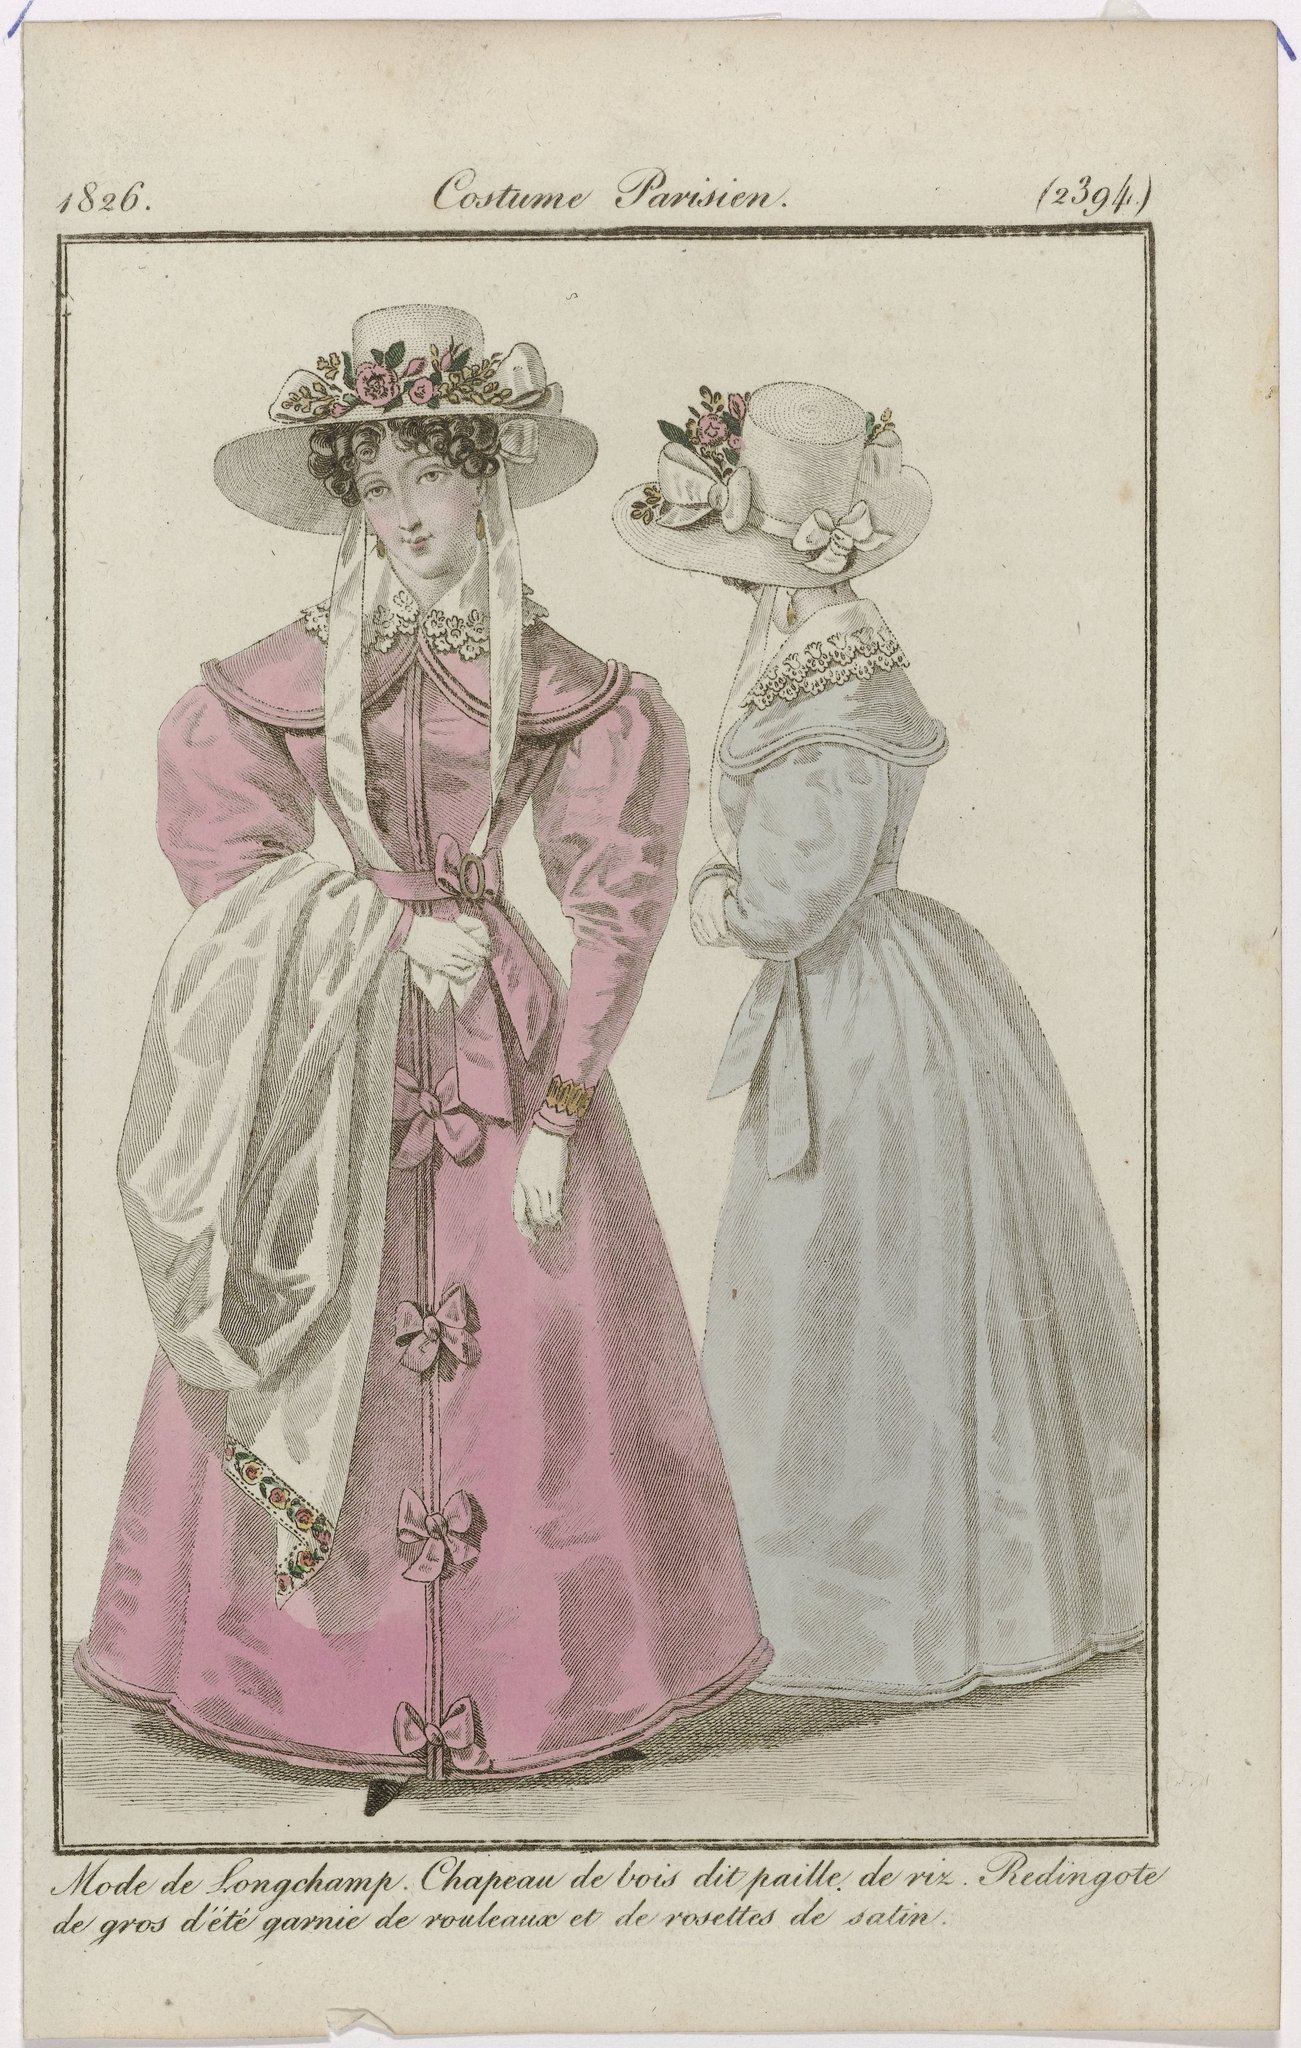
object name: fashion print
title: Journal des Dames et des Modes, Costume Parisien, 25 mars 1826, (2394): Mode de Longchamp (...)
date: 1826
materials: paper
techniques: engraving, hand coloring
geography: paris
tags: handkerchief (+ women's clothes), ornamental parts of clothing (+ women's clothes), dress, gown: redingote (+ women's clothes), fashion plates, head-gear: hat (+ women's clothes), shoes, sandals (+ women's clothes), bracelet, wristlet (+ women's clothes), belt, girdle, waistband (+ women's clothes)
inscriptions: title: ‘Costume Parisien.’, caption: ‘Mode de Longchamp. Chapeau de bois dit paille de riz. Redingote de gros d'été garnie de rouleaux et de rosettes de satin.’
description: 'Mode de Longchamp.' Vrouw gekleed in een redingote van 'gros d'été' gegarneerd met een 'rouleaux' en rozetten van satijn. Schapenboutmouwen. Op het hoofd een hoed van 'paille de riz'. Verdere accessoires: oorbellen, ceintuur, sjaal, zakdoek, armband om de linkerpols. Figuur in eenzelfde redingote, op de rug gezien. De prent maakt deel uit van het modetijdschrift Journal des Dames et des Modes, uitgegeven door Pierre de la Mésangère, Parijs, 1797-1839.